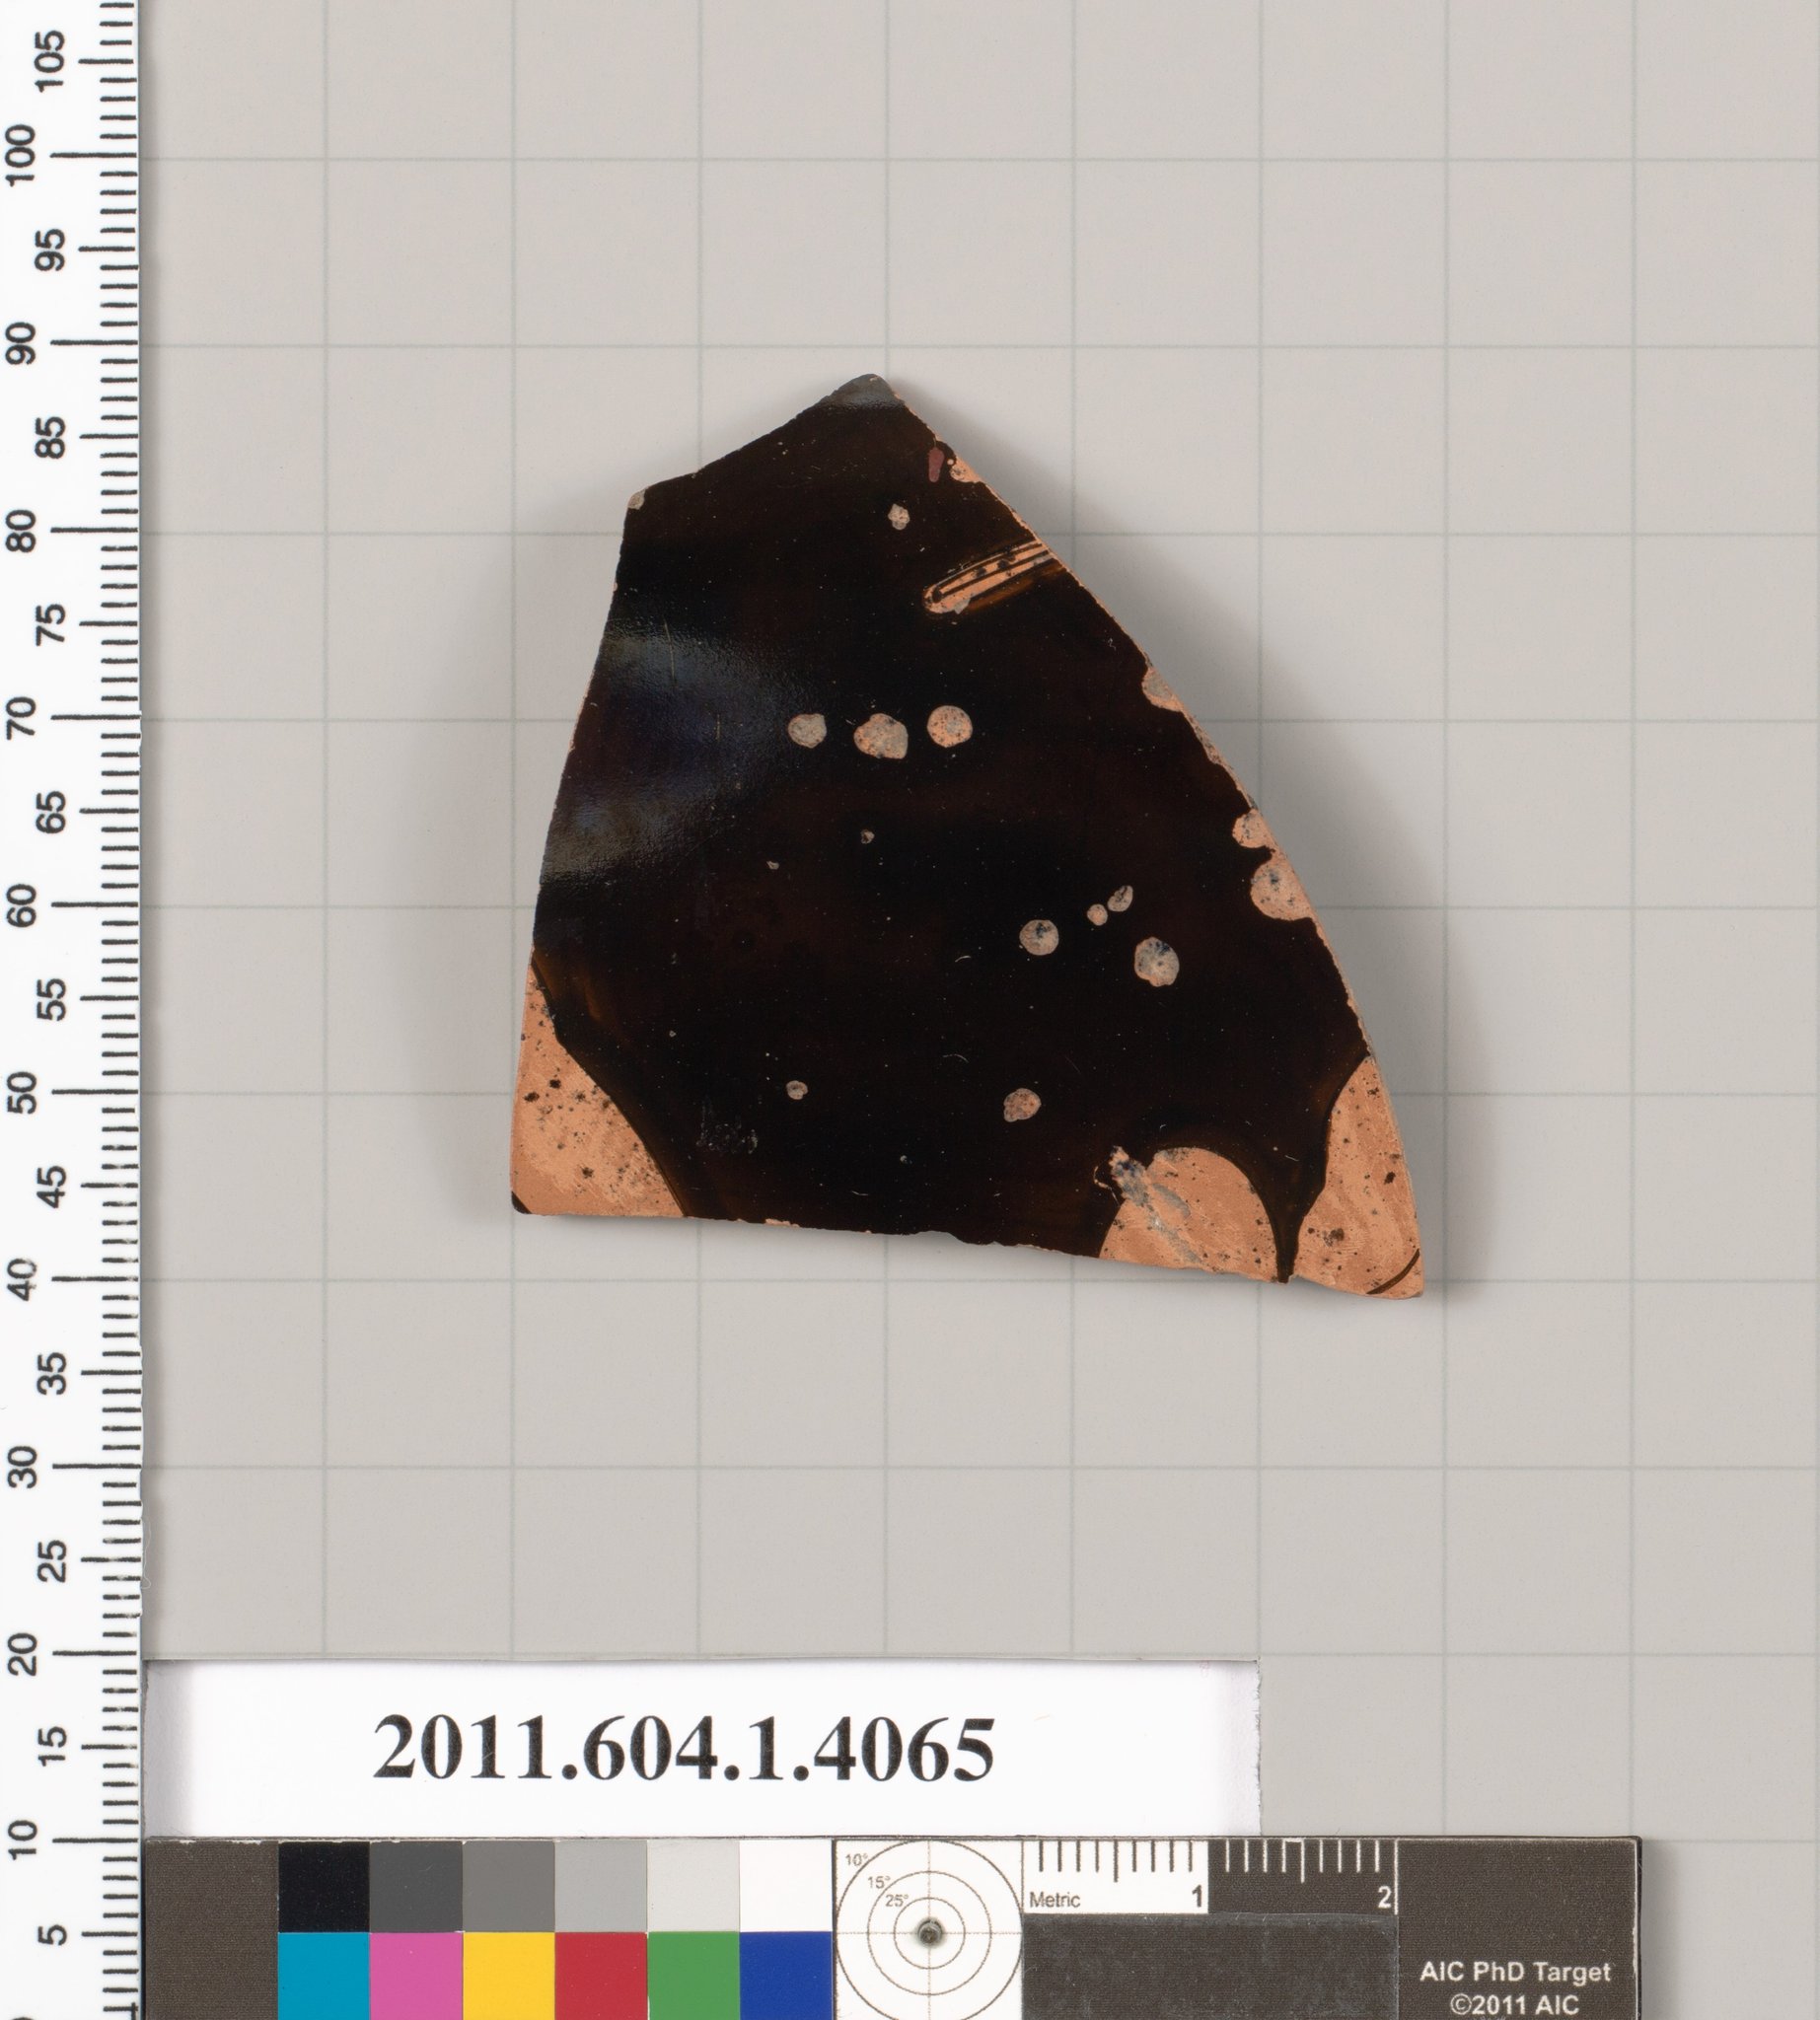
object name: kylix or skyphos fragment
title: Terracotta fragment of a kylix or skyphos?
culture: greek, attic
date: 500-451 BCE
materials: terracotta